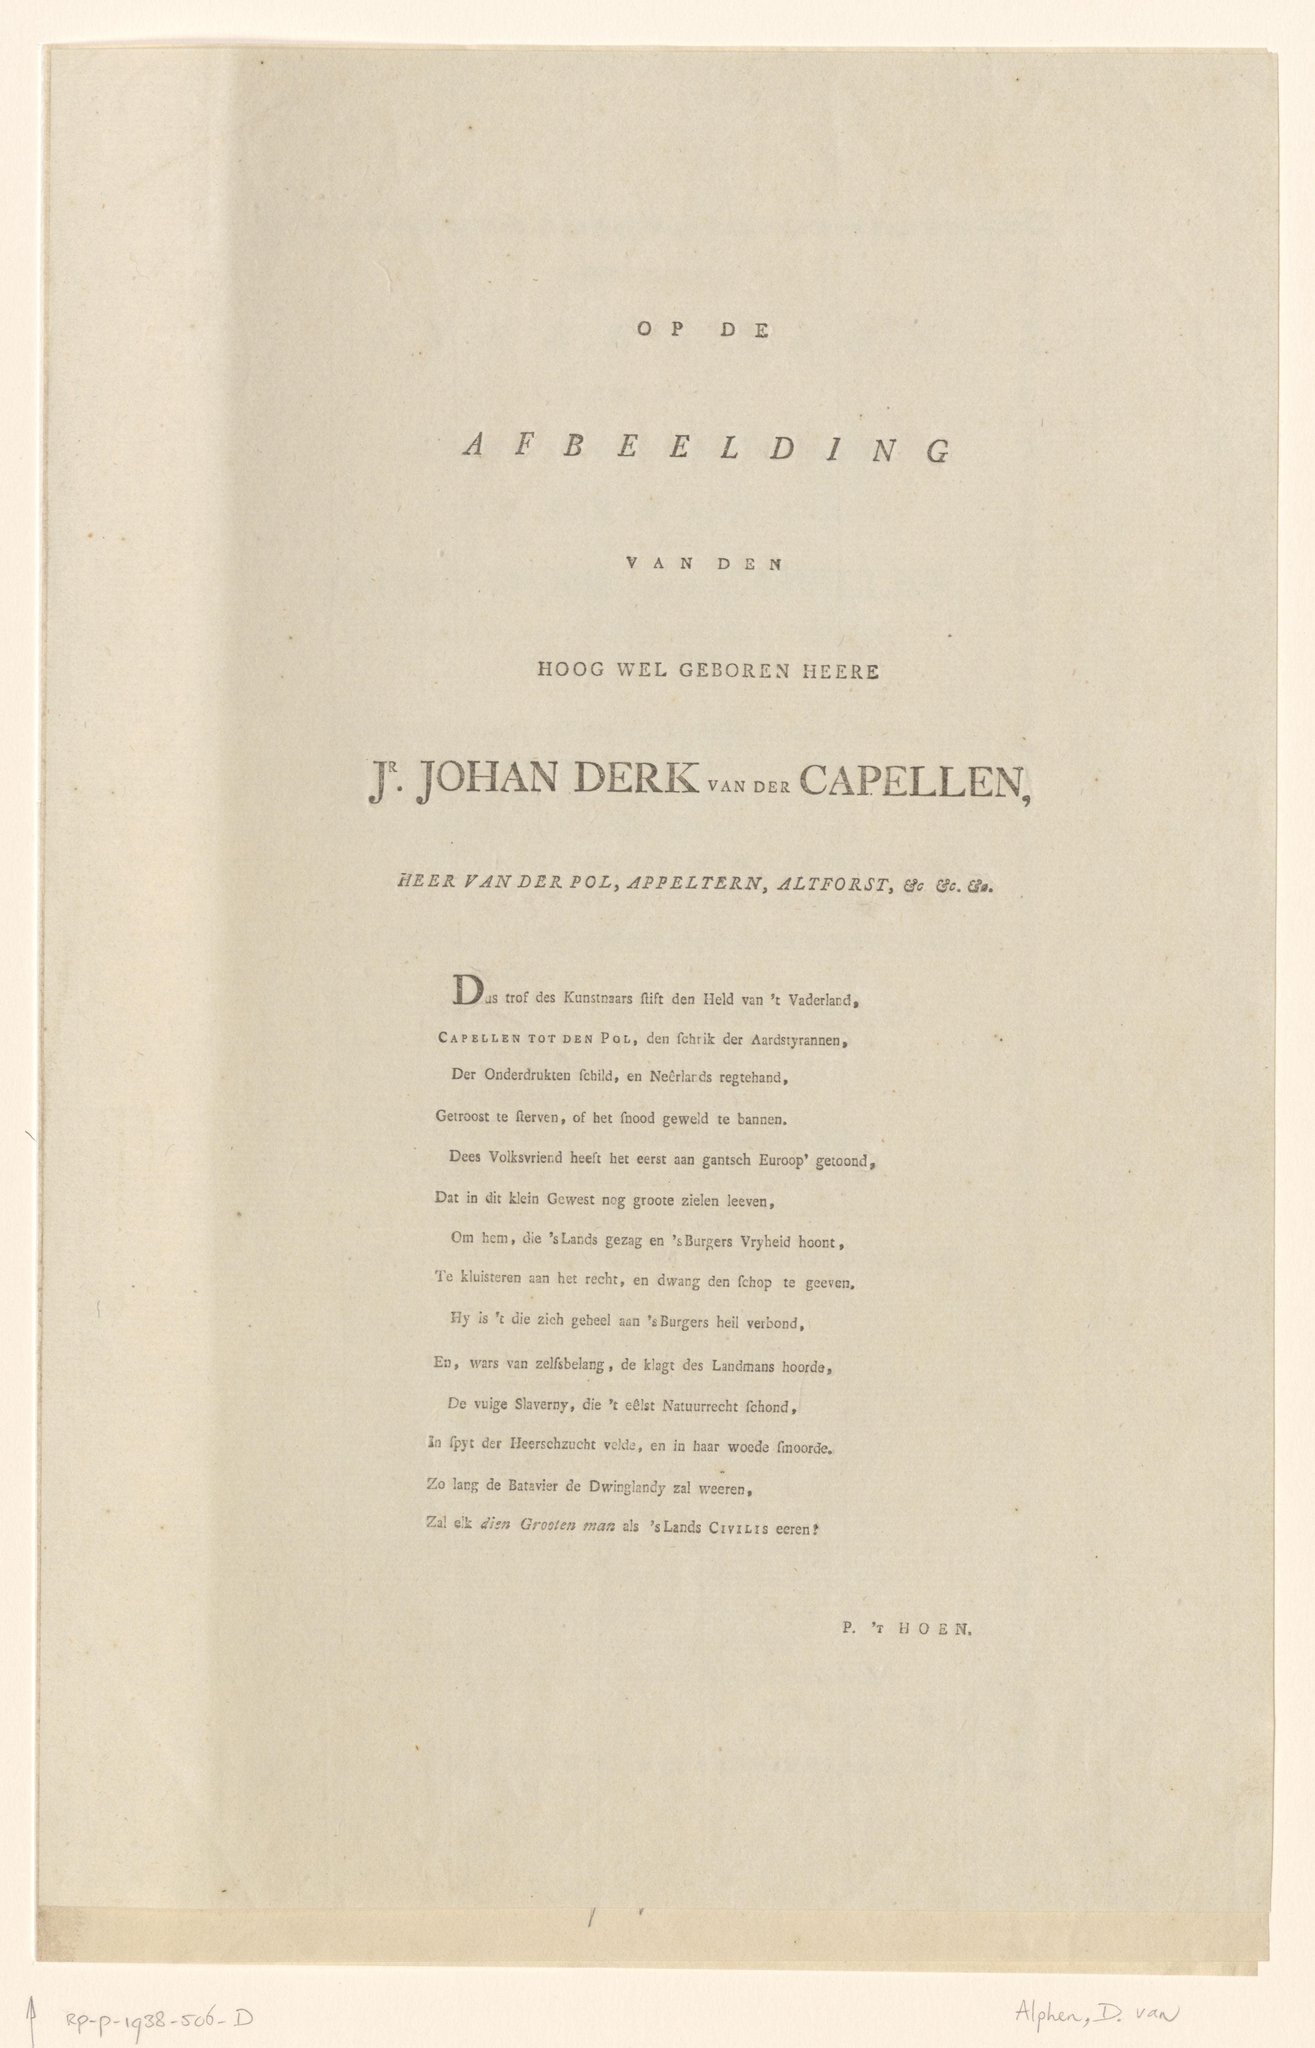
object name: text sheet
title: Vijf lofdichten op de politicus Joan Derk van der Capellen tot den Pol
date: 1785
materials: paper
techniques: letterpress printing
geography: dordrecht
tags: joan derk van der capellen tot den pol, historical persons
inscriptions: date